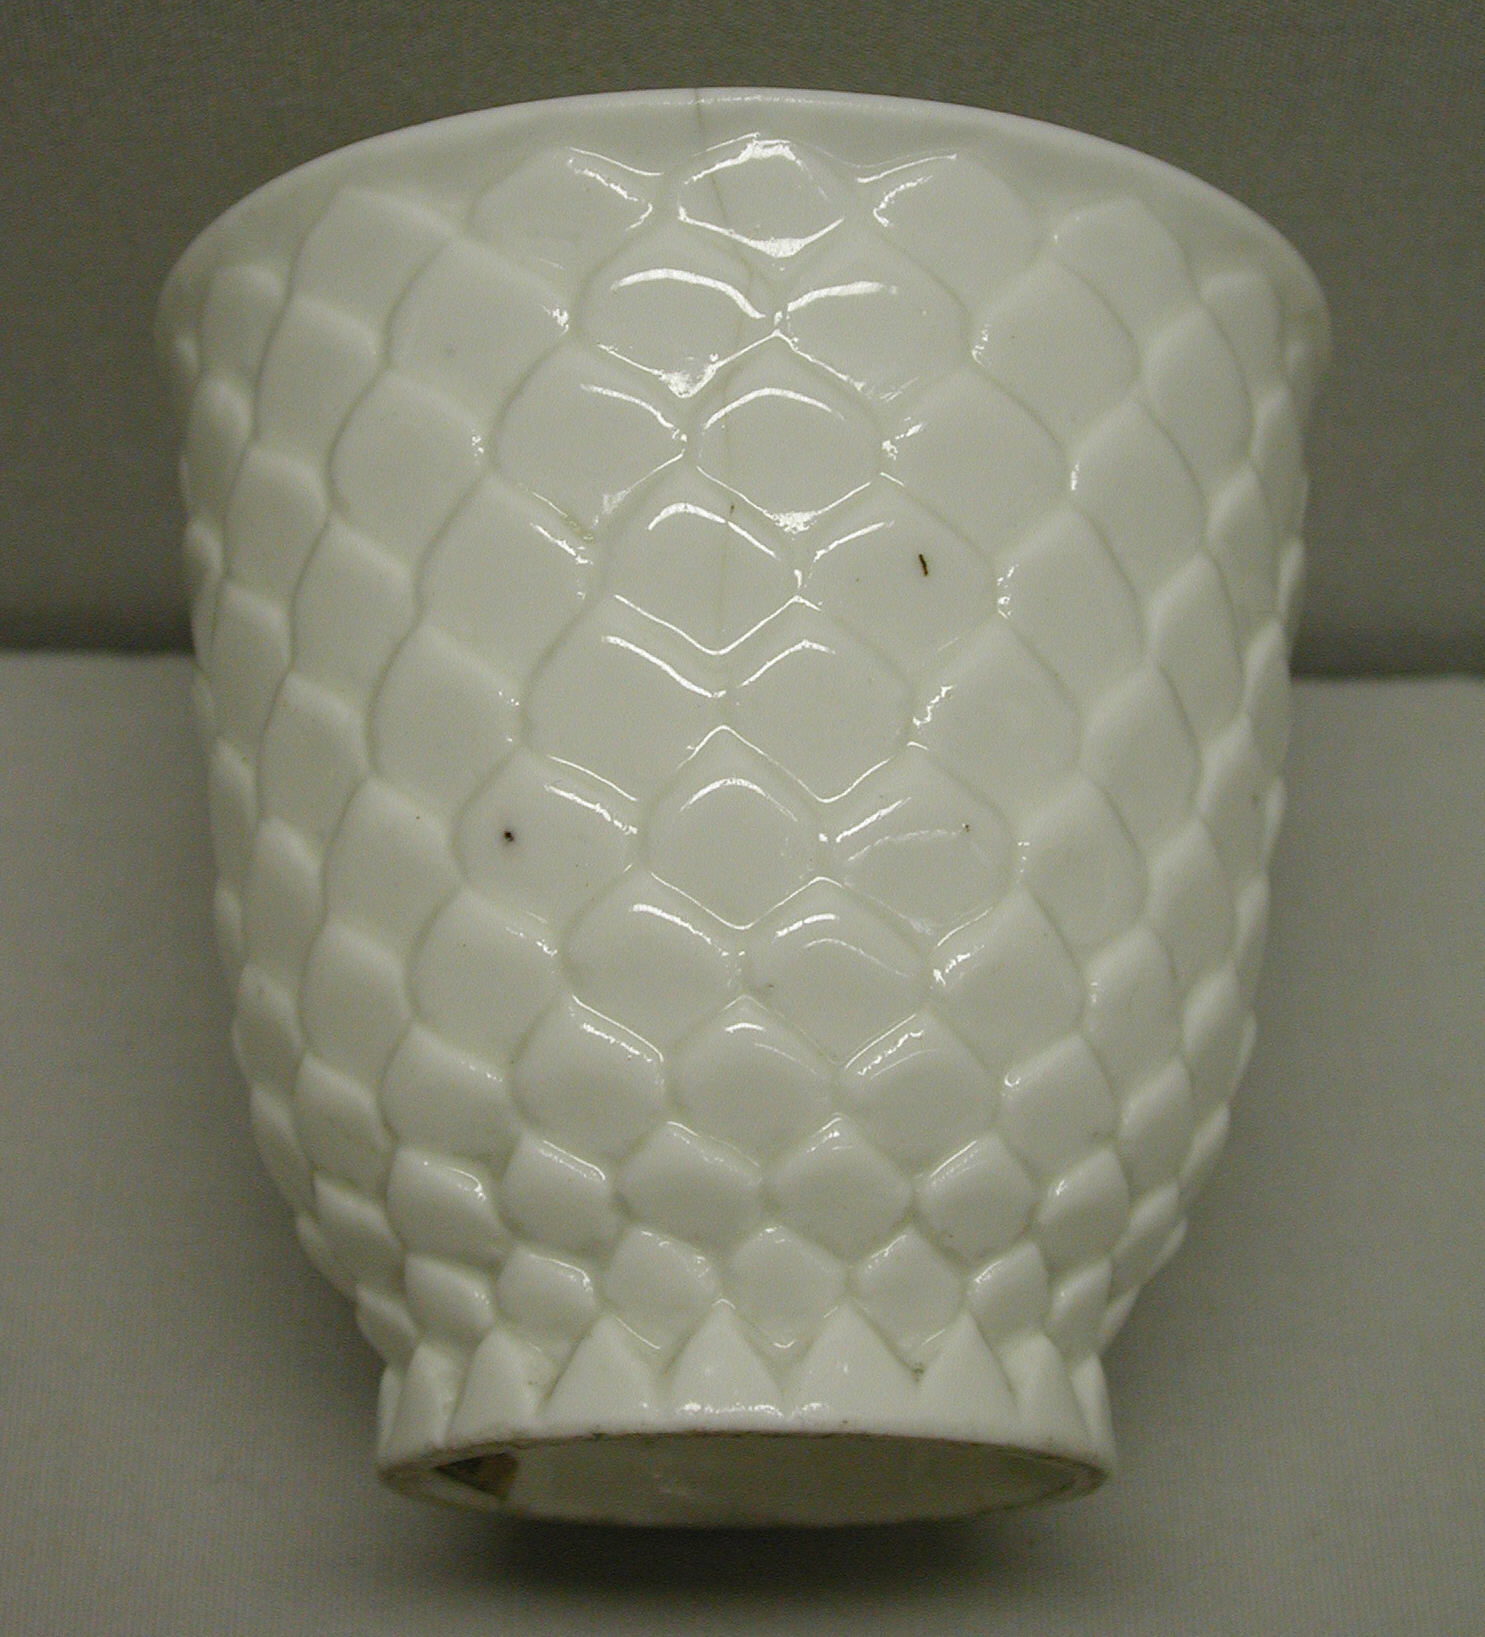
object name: cup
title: Cup (one of a pair)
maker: saint-cloud factory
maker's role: factory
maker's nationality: french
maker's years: 1693-1766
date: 1725-1740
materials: soft paste porcelain